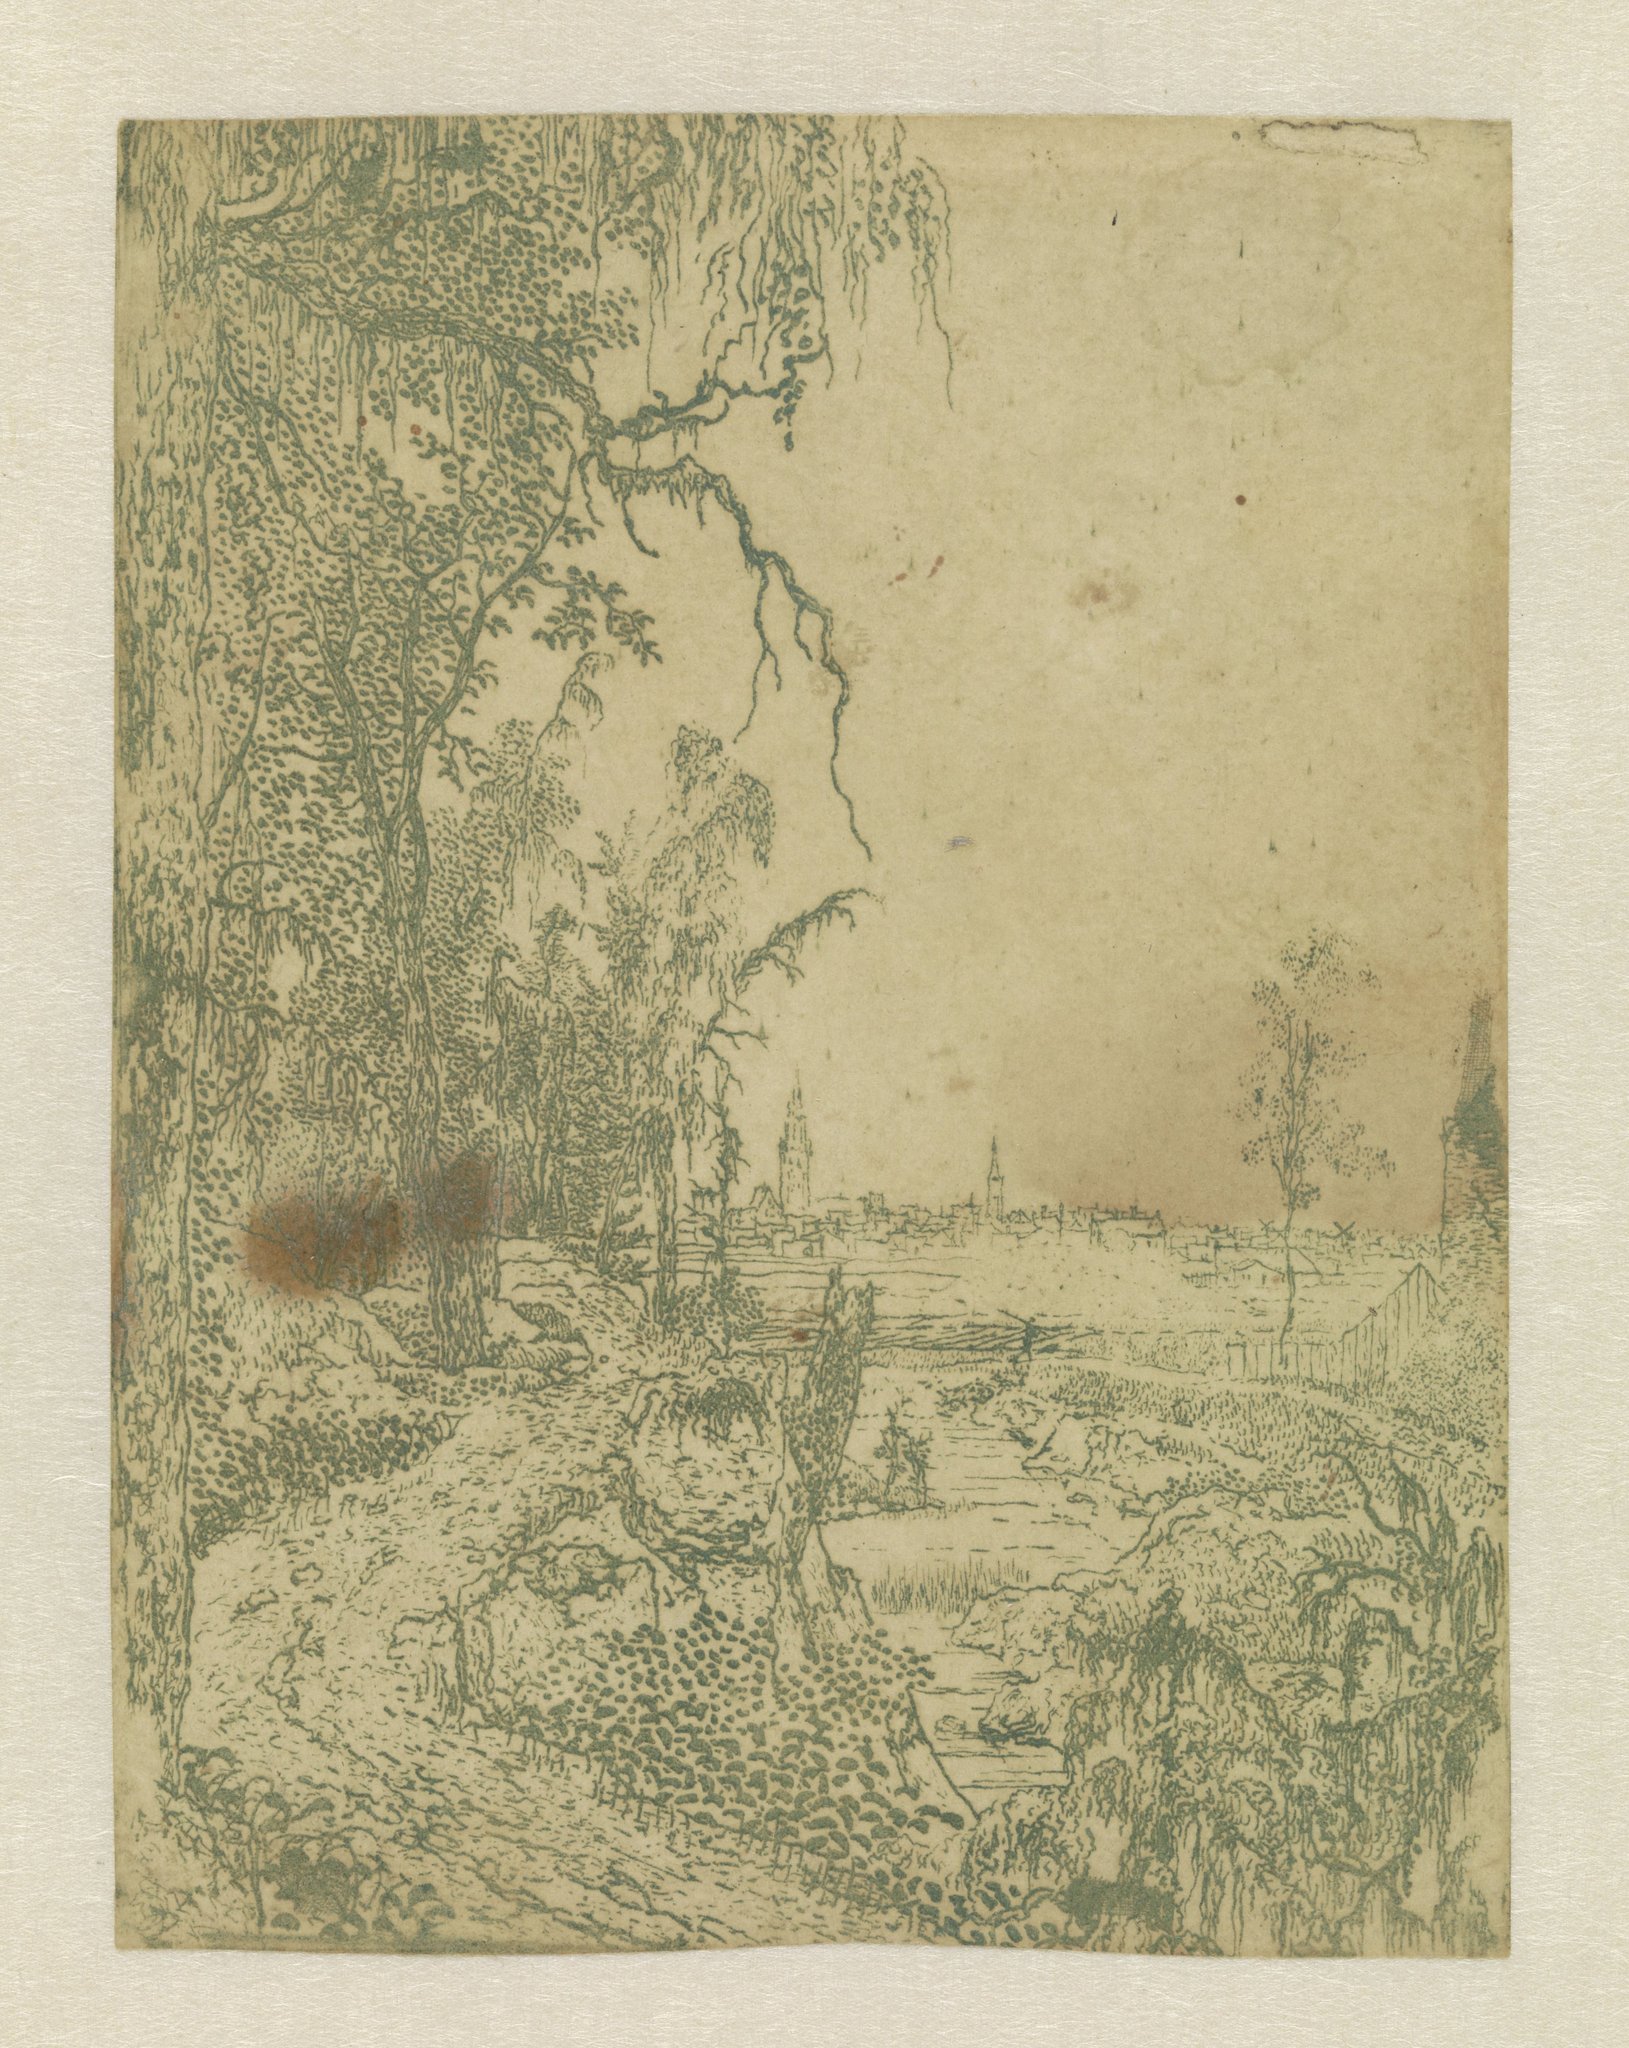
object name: print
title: A Road Bordered by Trees, a City in the Background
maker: hercules segers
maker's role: draughtsman, painter, print maker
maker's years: 1589-1640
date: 1622-1625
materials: paper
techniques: aquatint, lift ground etching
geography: amsterdam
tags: city-view in general; 'veduta', fringe, edge of the wood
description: Pad langs bosrand. In de verte een stad met twee kerktorens, dit zou Amersfoort kunnen zijn.